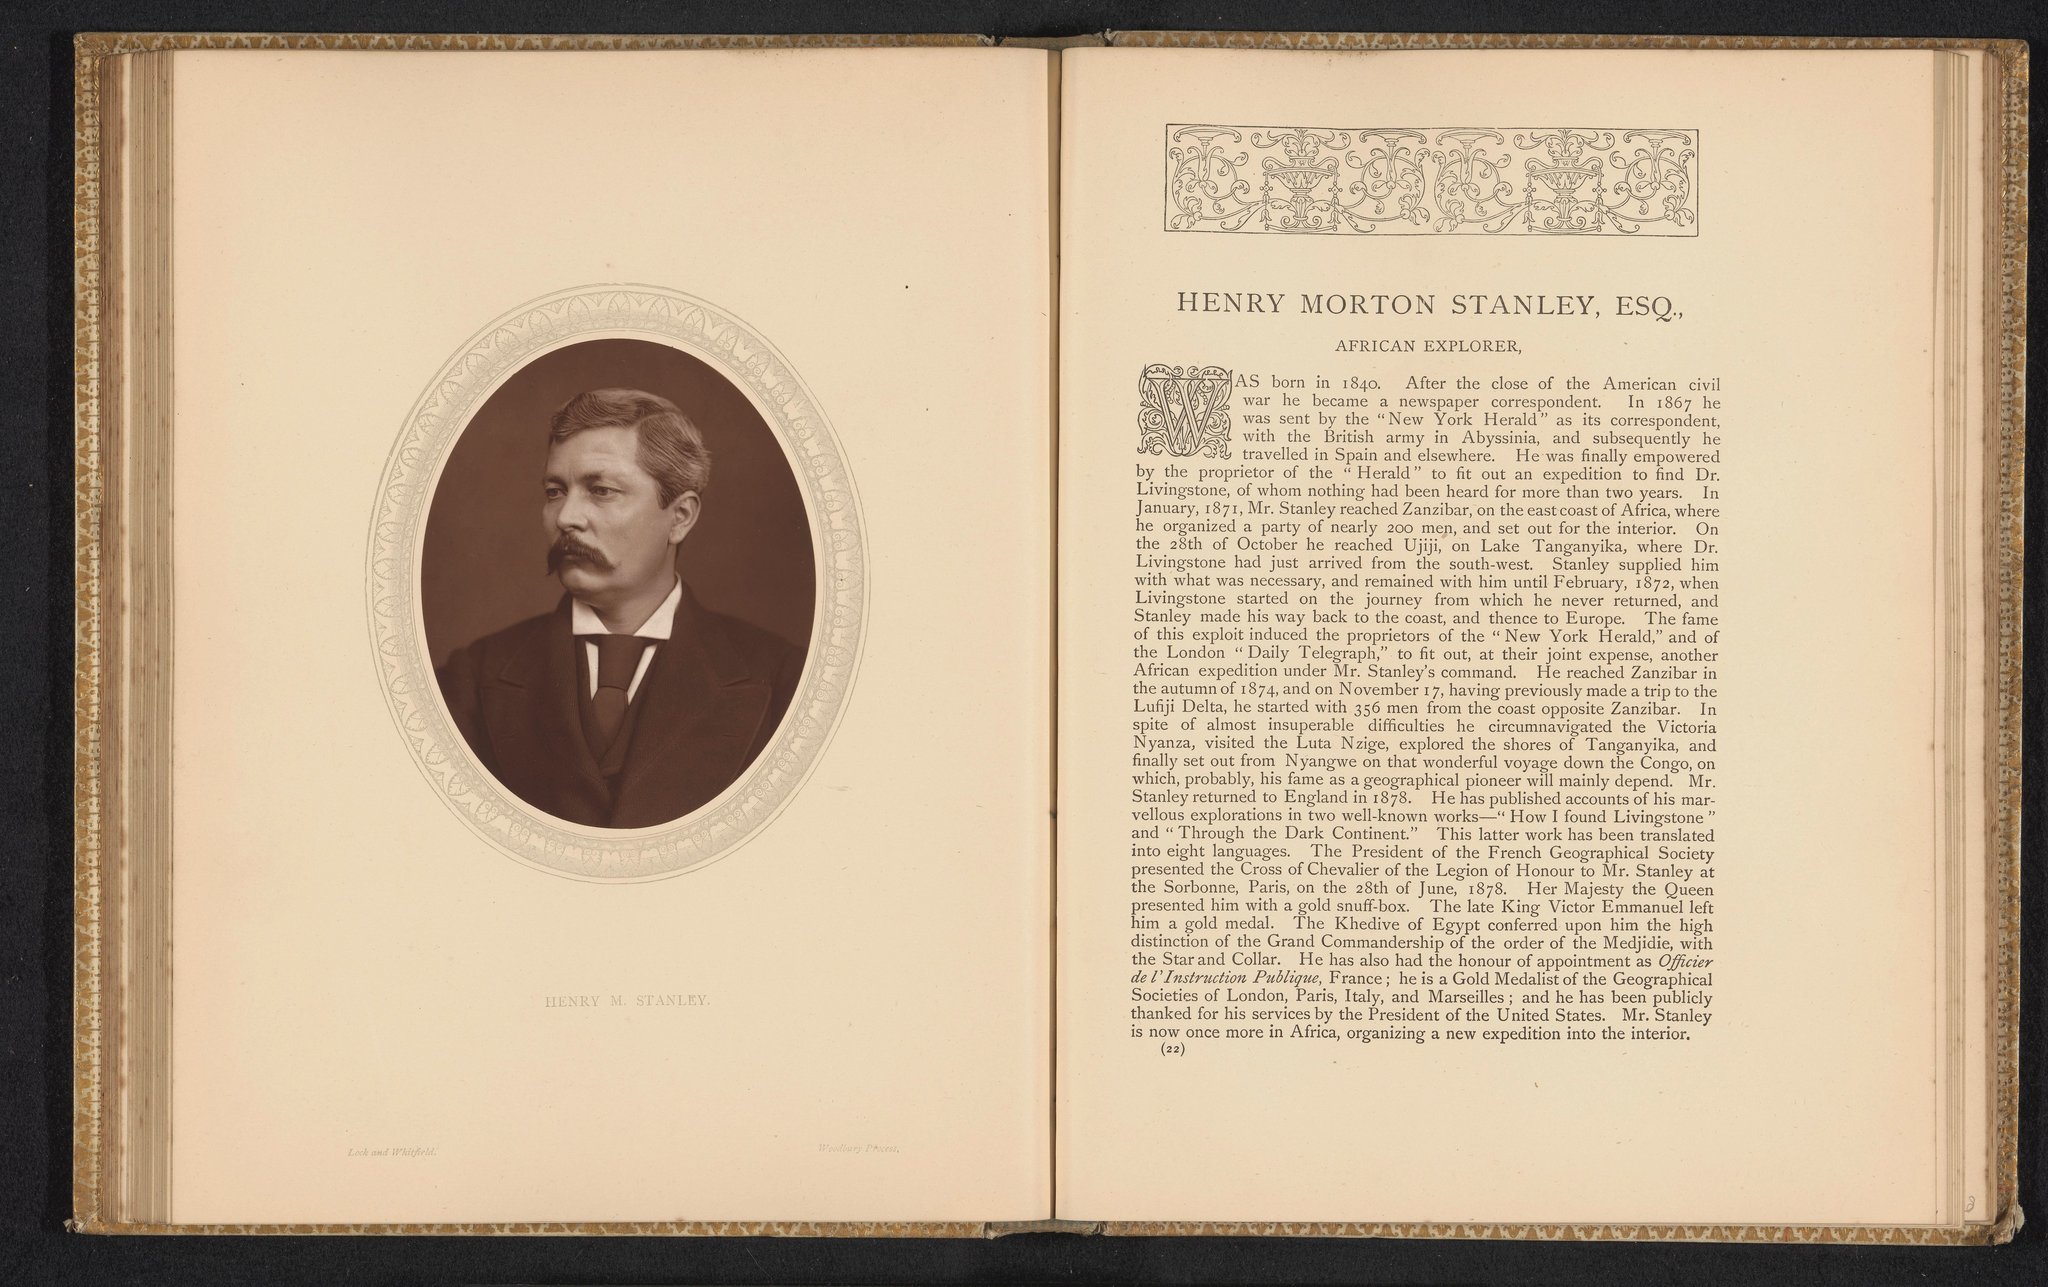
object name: page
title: Henry M. Stanley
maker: Anonymous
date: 1875-1880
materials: paper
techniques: woodburytype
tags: historical persons (portraits and scenes from the life) (+ (full) bust portrait), explorer